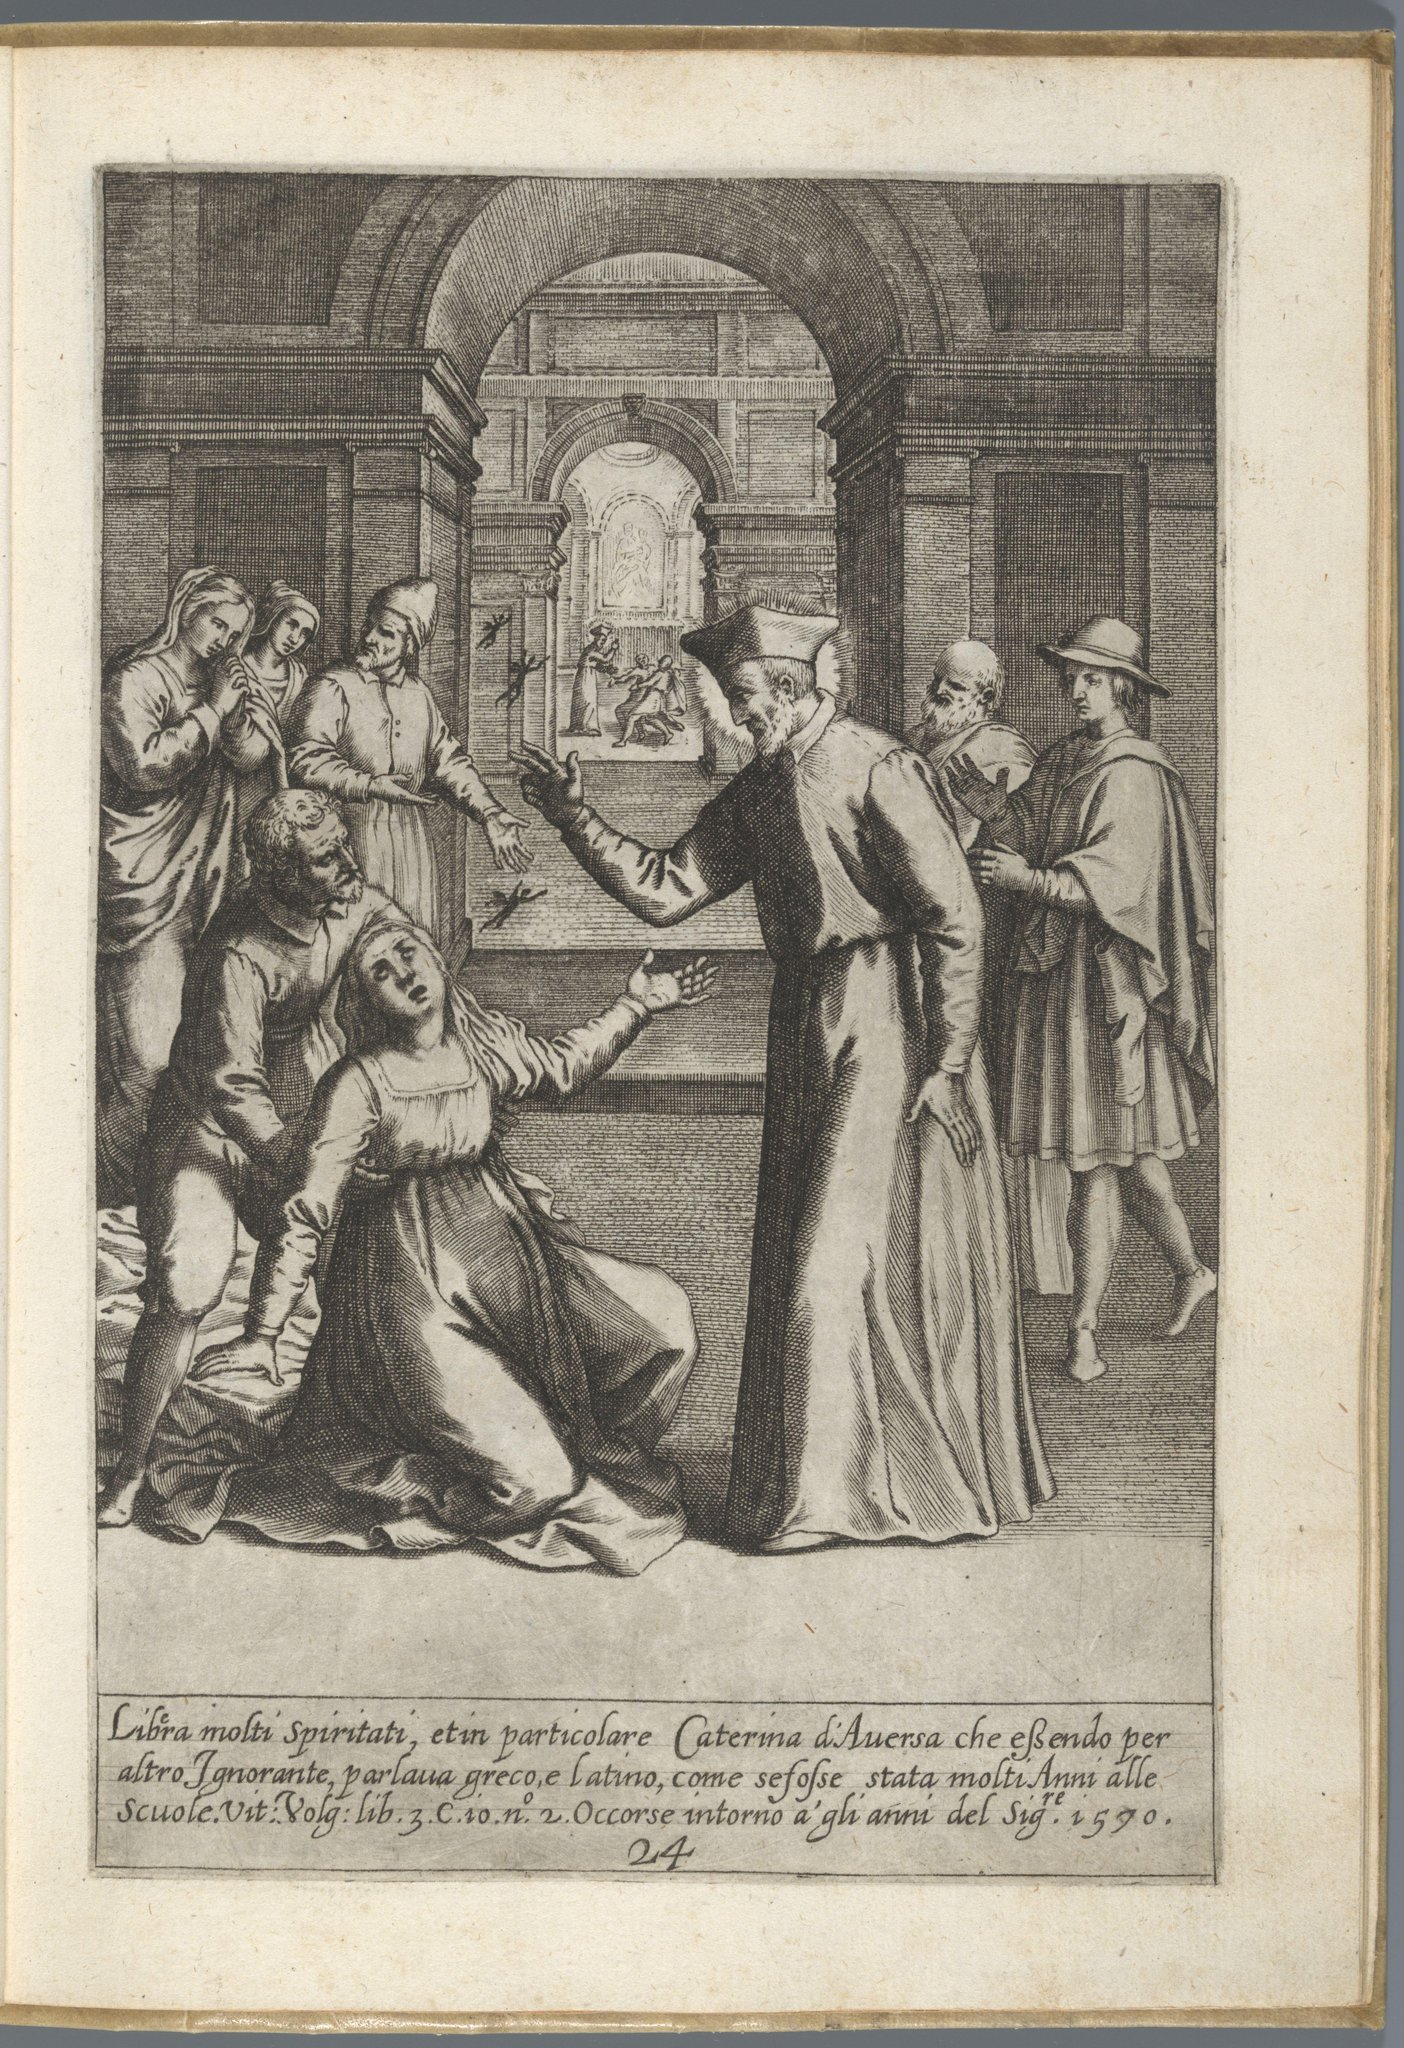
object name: print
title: Filippo Neri geneest de bezeten Caterina d'Aversa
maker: luca ciamberlano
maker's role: painter, print maker, publisher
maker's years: 1570-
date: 1630-1641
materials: paper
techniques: engraving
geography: rome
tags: the founder of the congregation of the oratory (oratorians) philip neri; possible attributes: lily, rosary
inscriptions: collector's mark: Lugt 2760, collector's mark: Lugt 2228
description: Filippo Neri geneest de bezeten Caterina d'Aversa (ca. 1570). Prent nr. 24 in een serie van 44 prenten met scènes uit het leven van de heilige Filippo Neri.